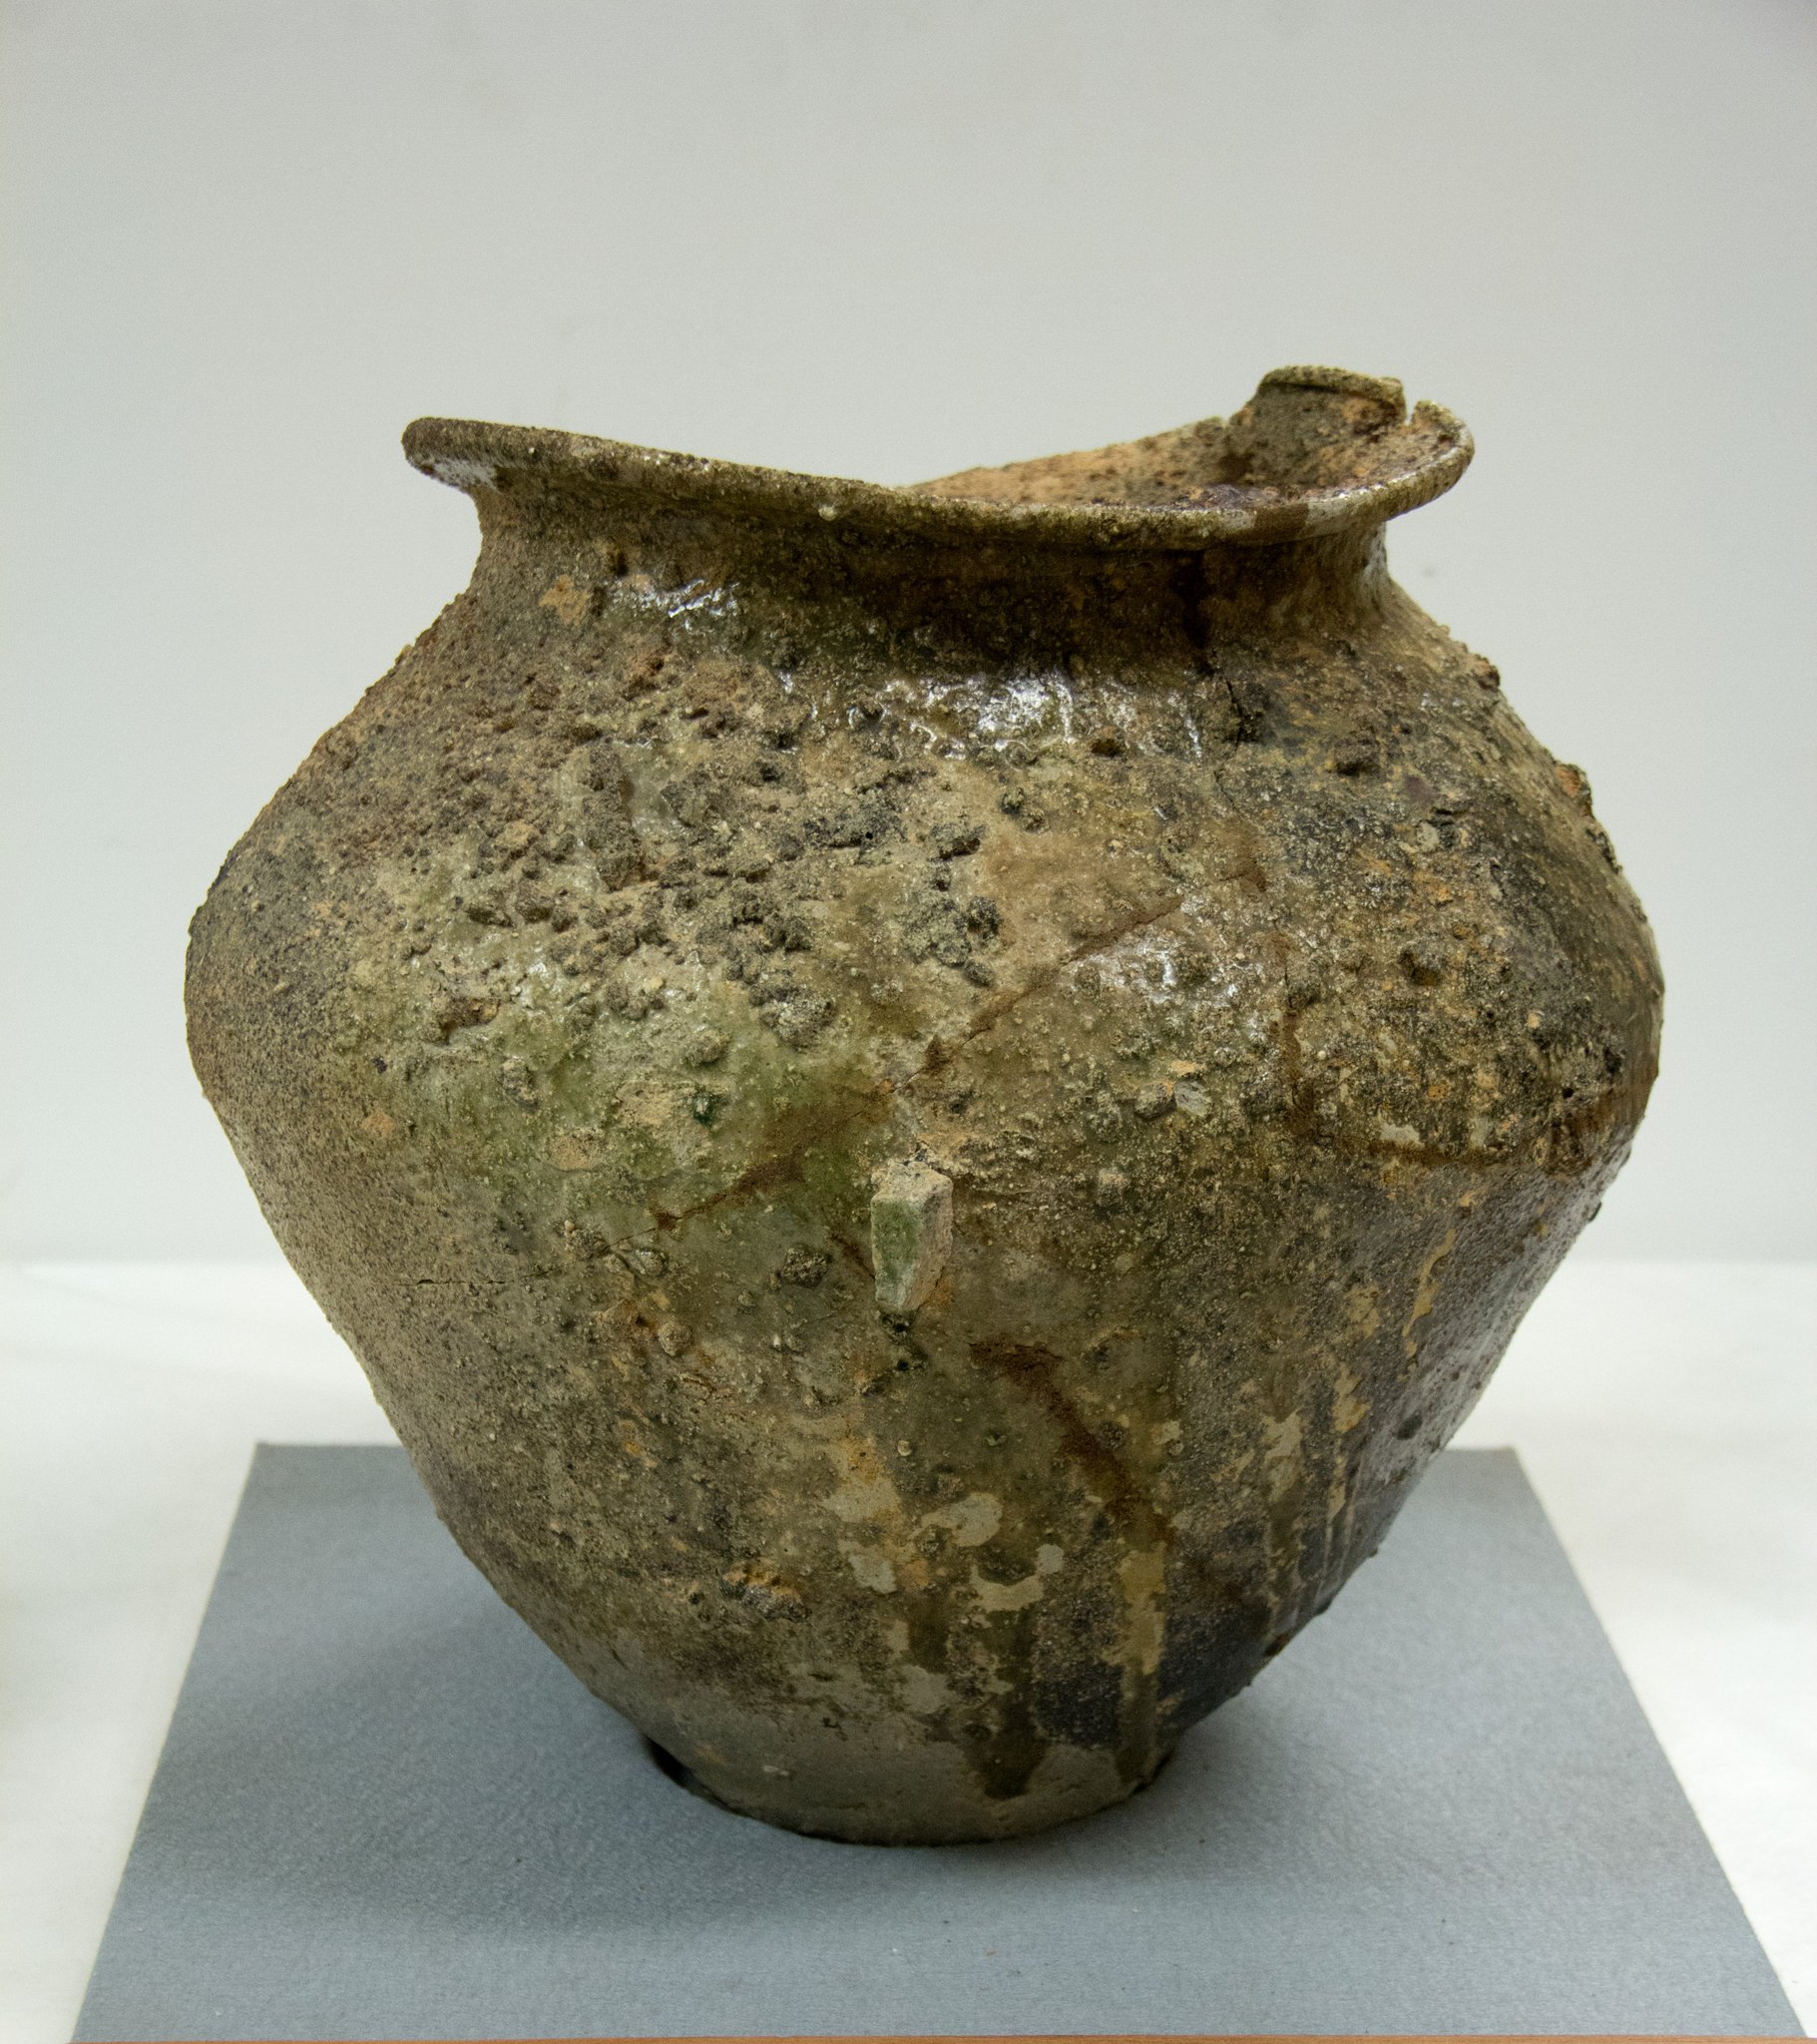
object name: jar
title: Storage jar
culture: japanese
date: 1101-1200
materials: wood, glaze, stoneware